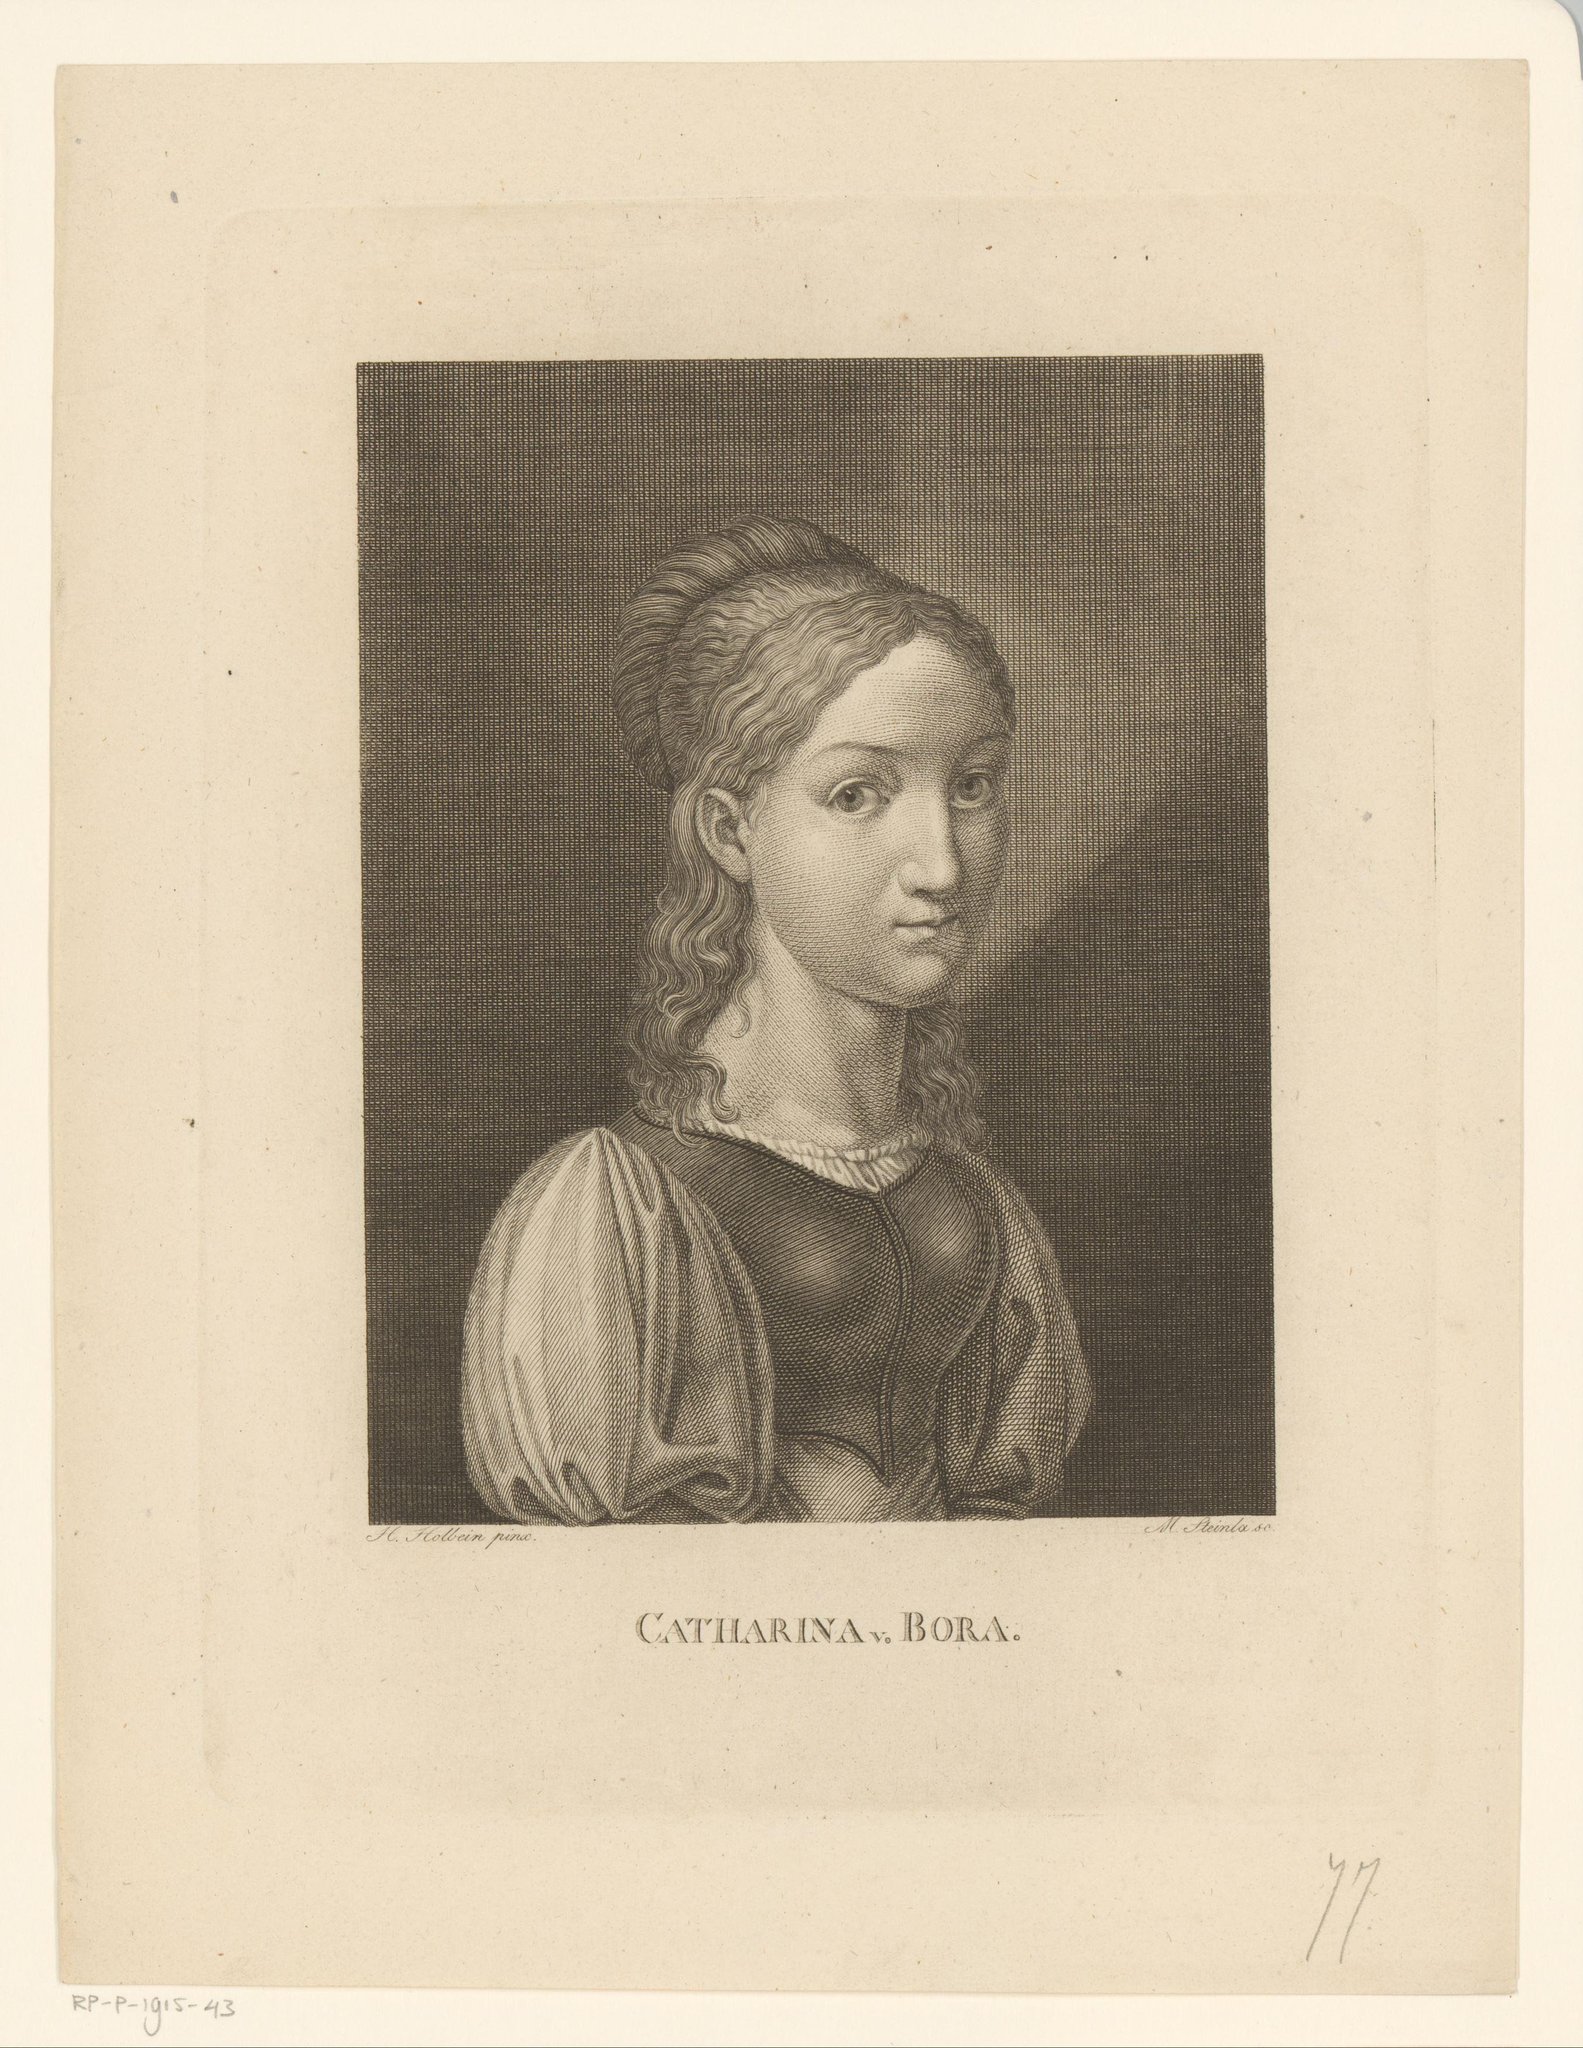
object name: print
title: Portret van Katharina von Bora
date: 1801-1858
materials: paper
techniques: engraving, etching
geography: germany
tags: historical persons - bb - woman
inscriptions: collector's mark: Lugt 2228